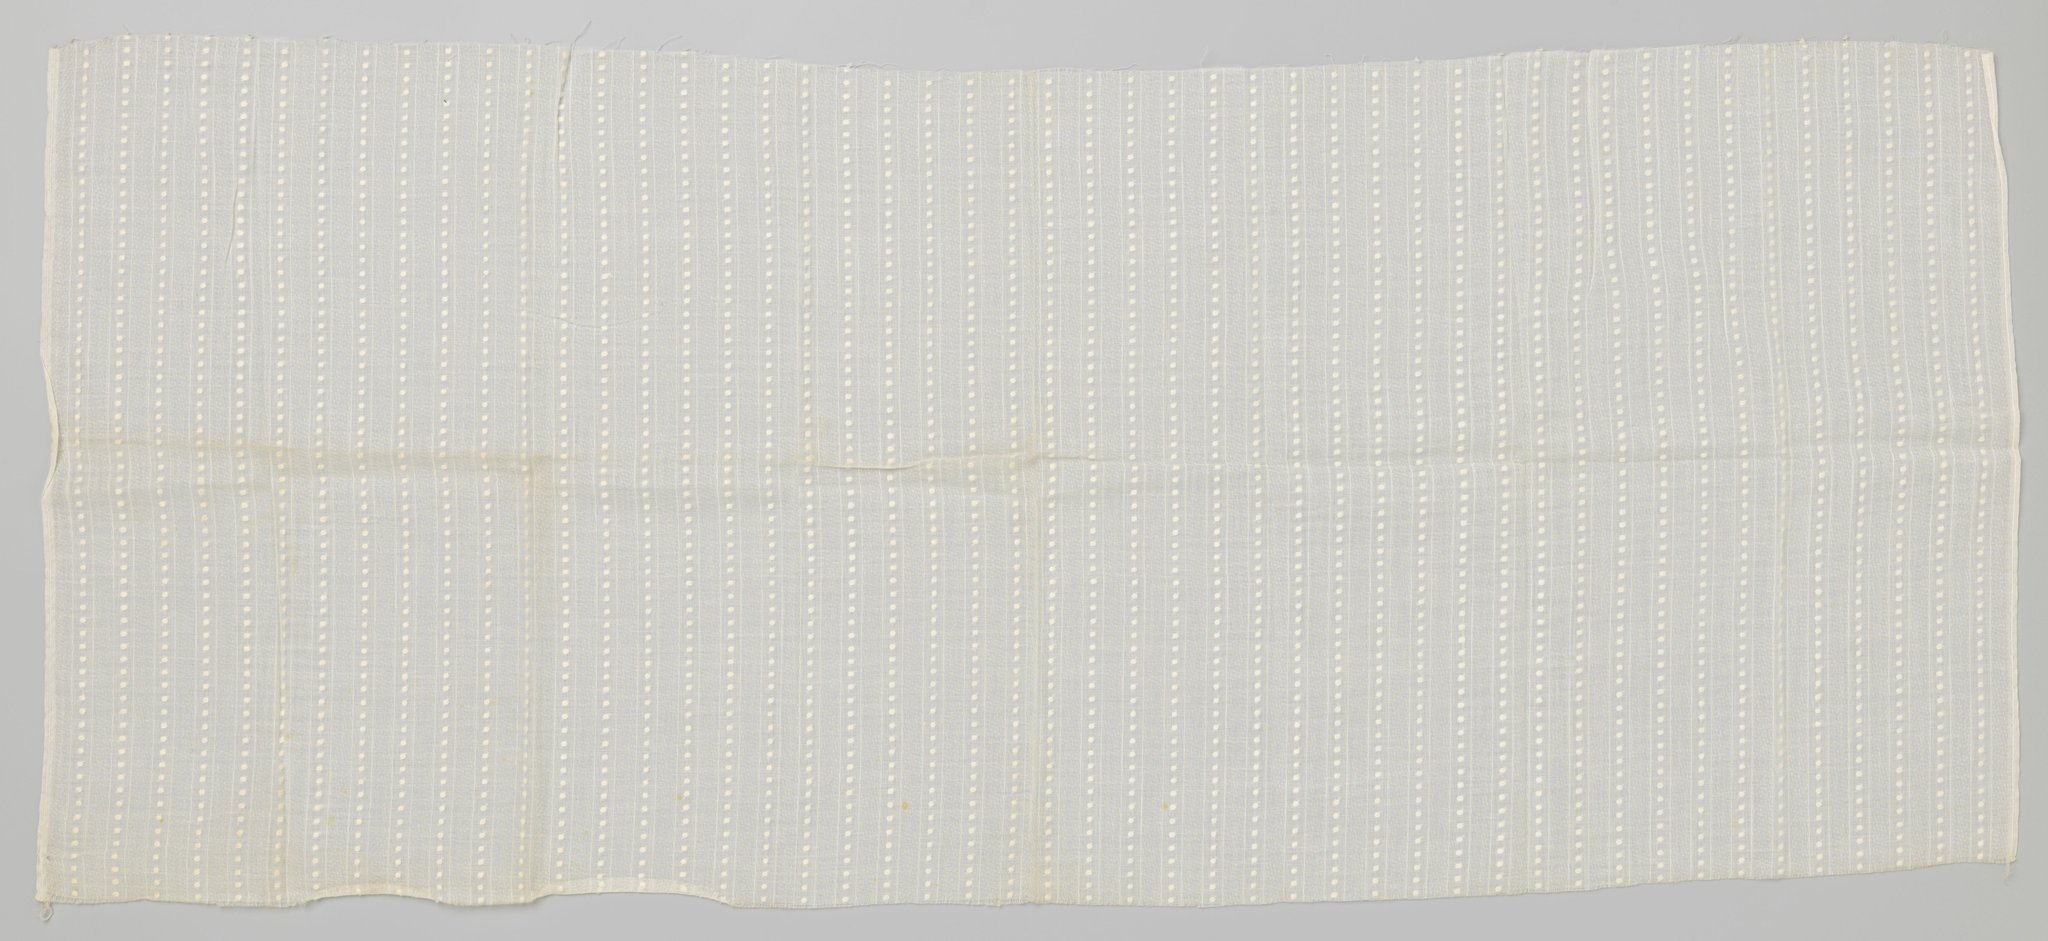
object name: fragment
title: Fragment genopt neteldoek, bestemd voor restauratie.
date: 1850-1972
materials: textile